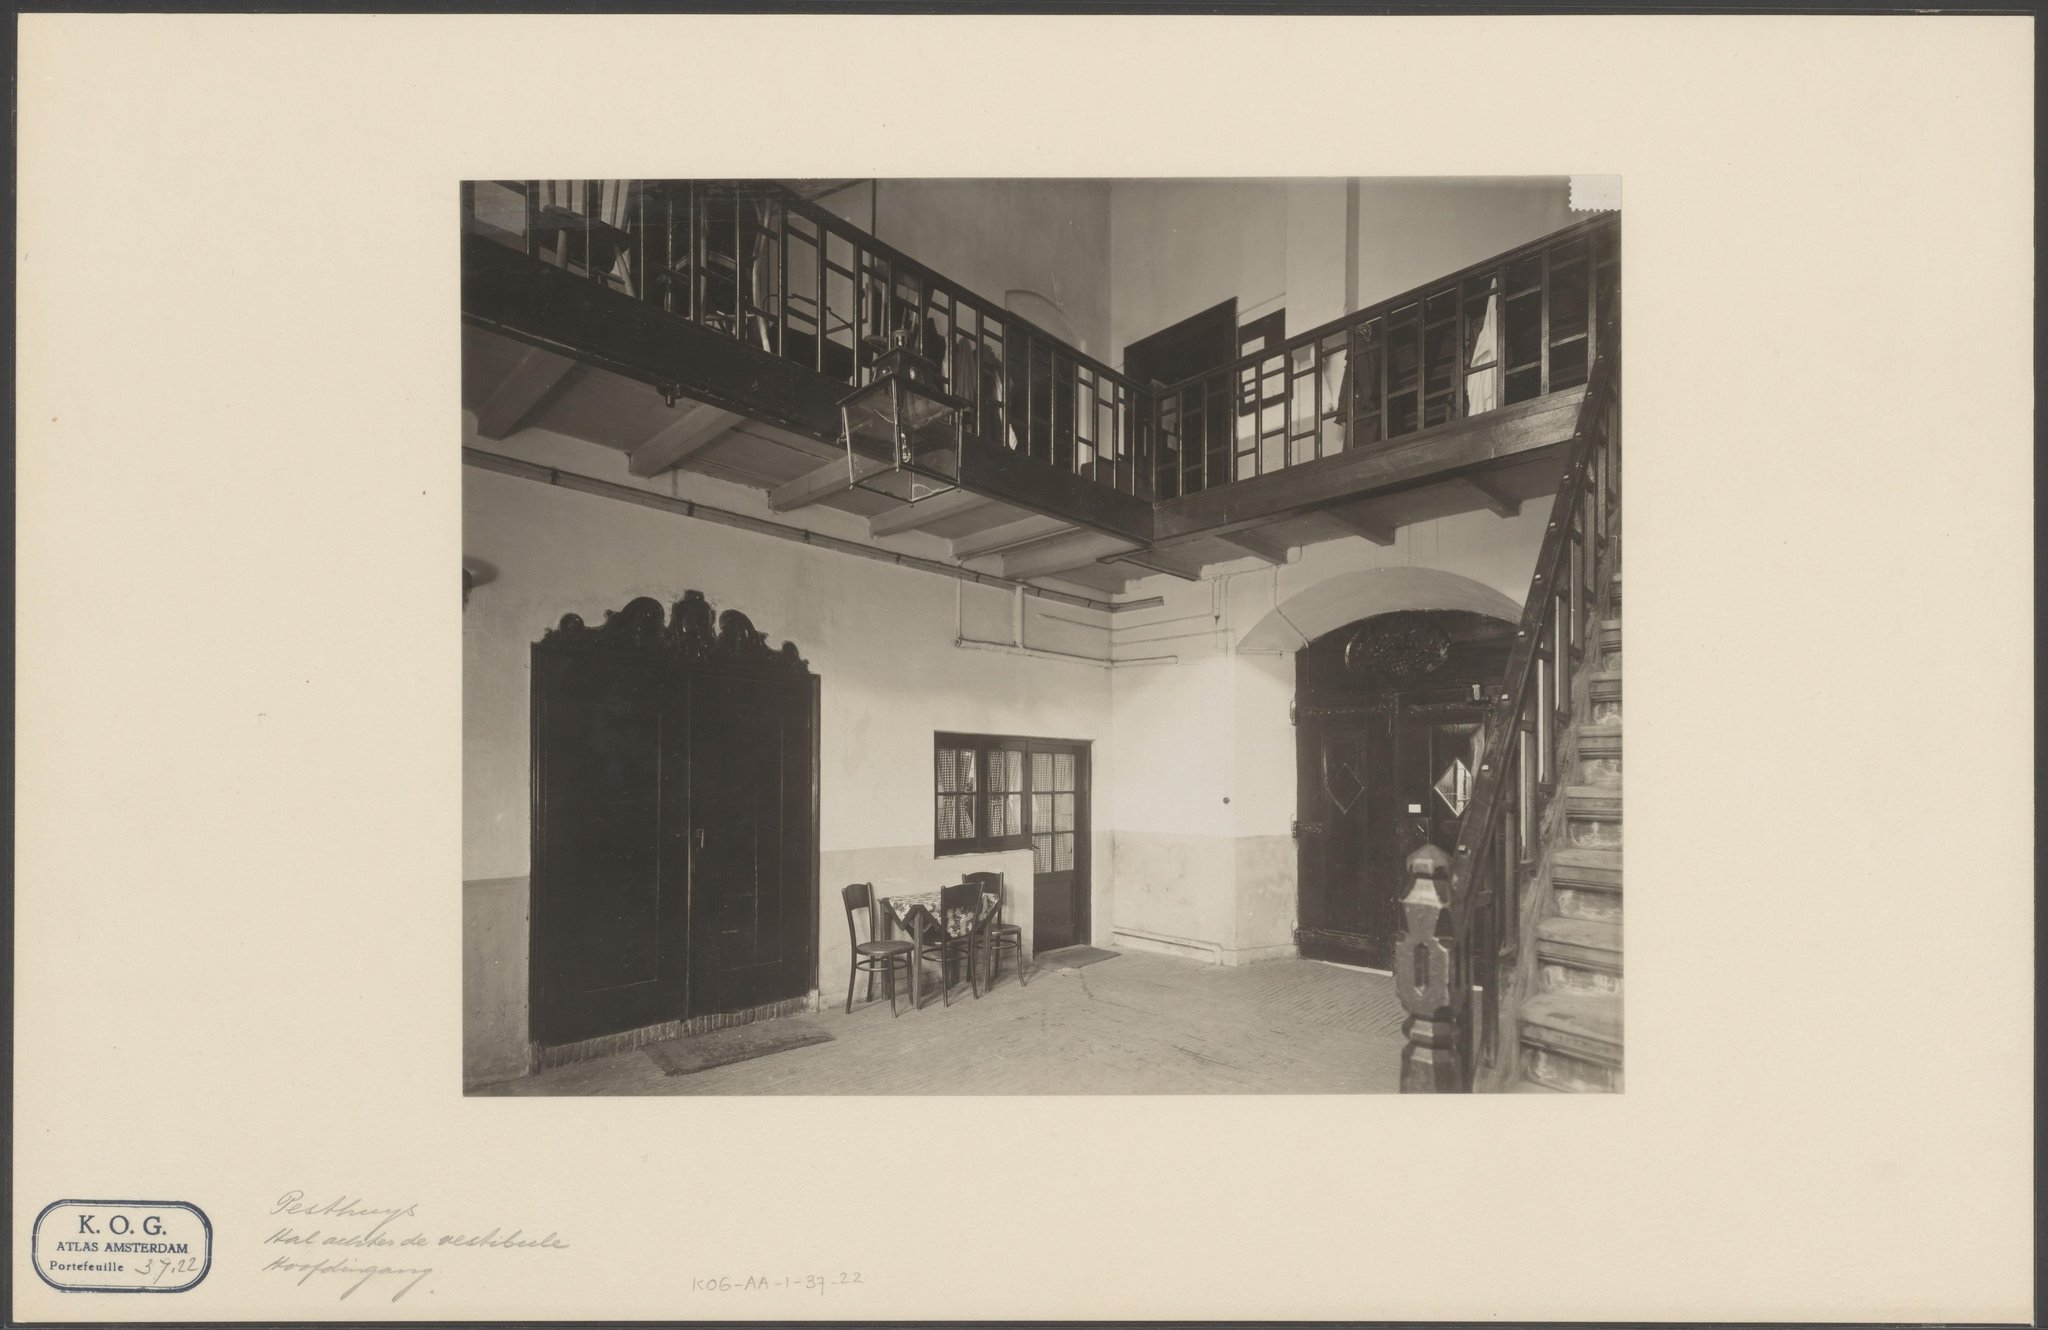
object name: photograph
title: Hoofdingang en vestibule van het Buitengasthuis te Amsterdam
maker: Anonymous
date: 1931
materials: paper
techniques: gelatin silver print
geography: amsterdam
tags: gate, entrance, vestibule, hall, hospital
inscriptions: collector's mark: Lugt 1641b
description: Onderwerpsrubriek binnen de Atlas Amsterdam: Armwezen en liefdadige instellingen: I. Stadsinrichtingen: Buitengasthuis (Pesthuis).